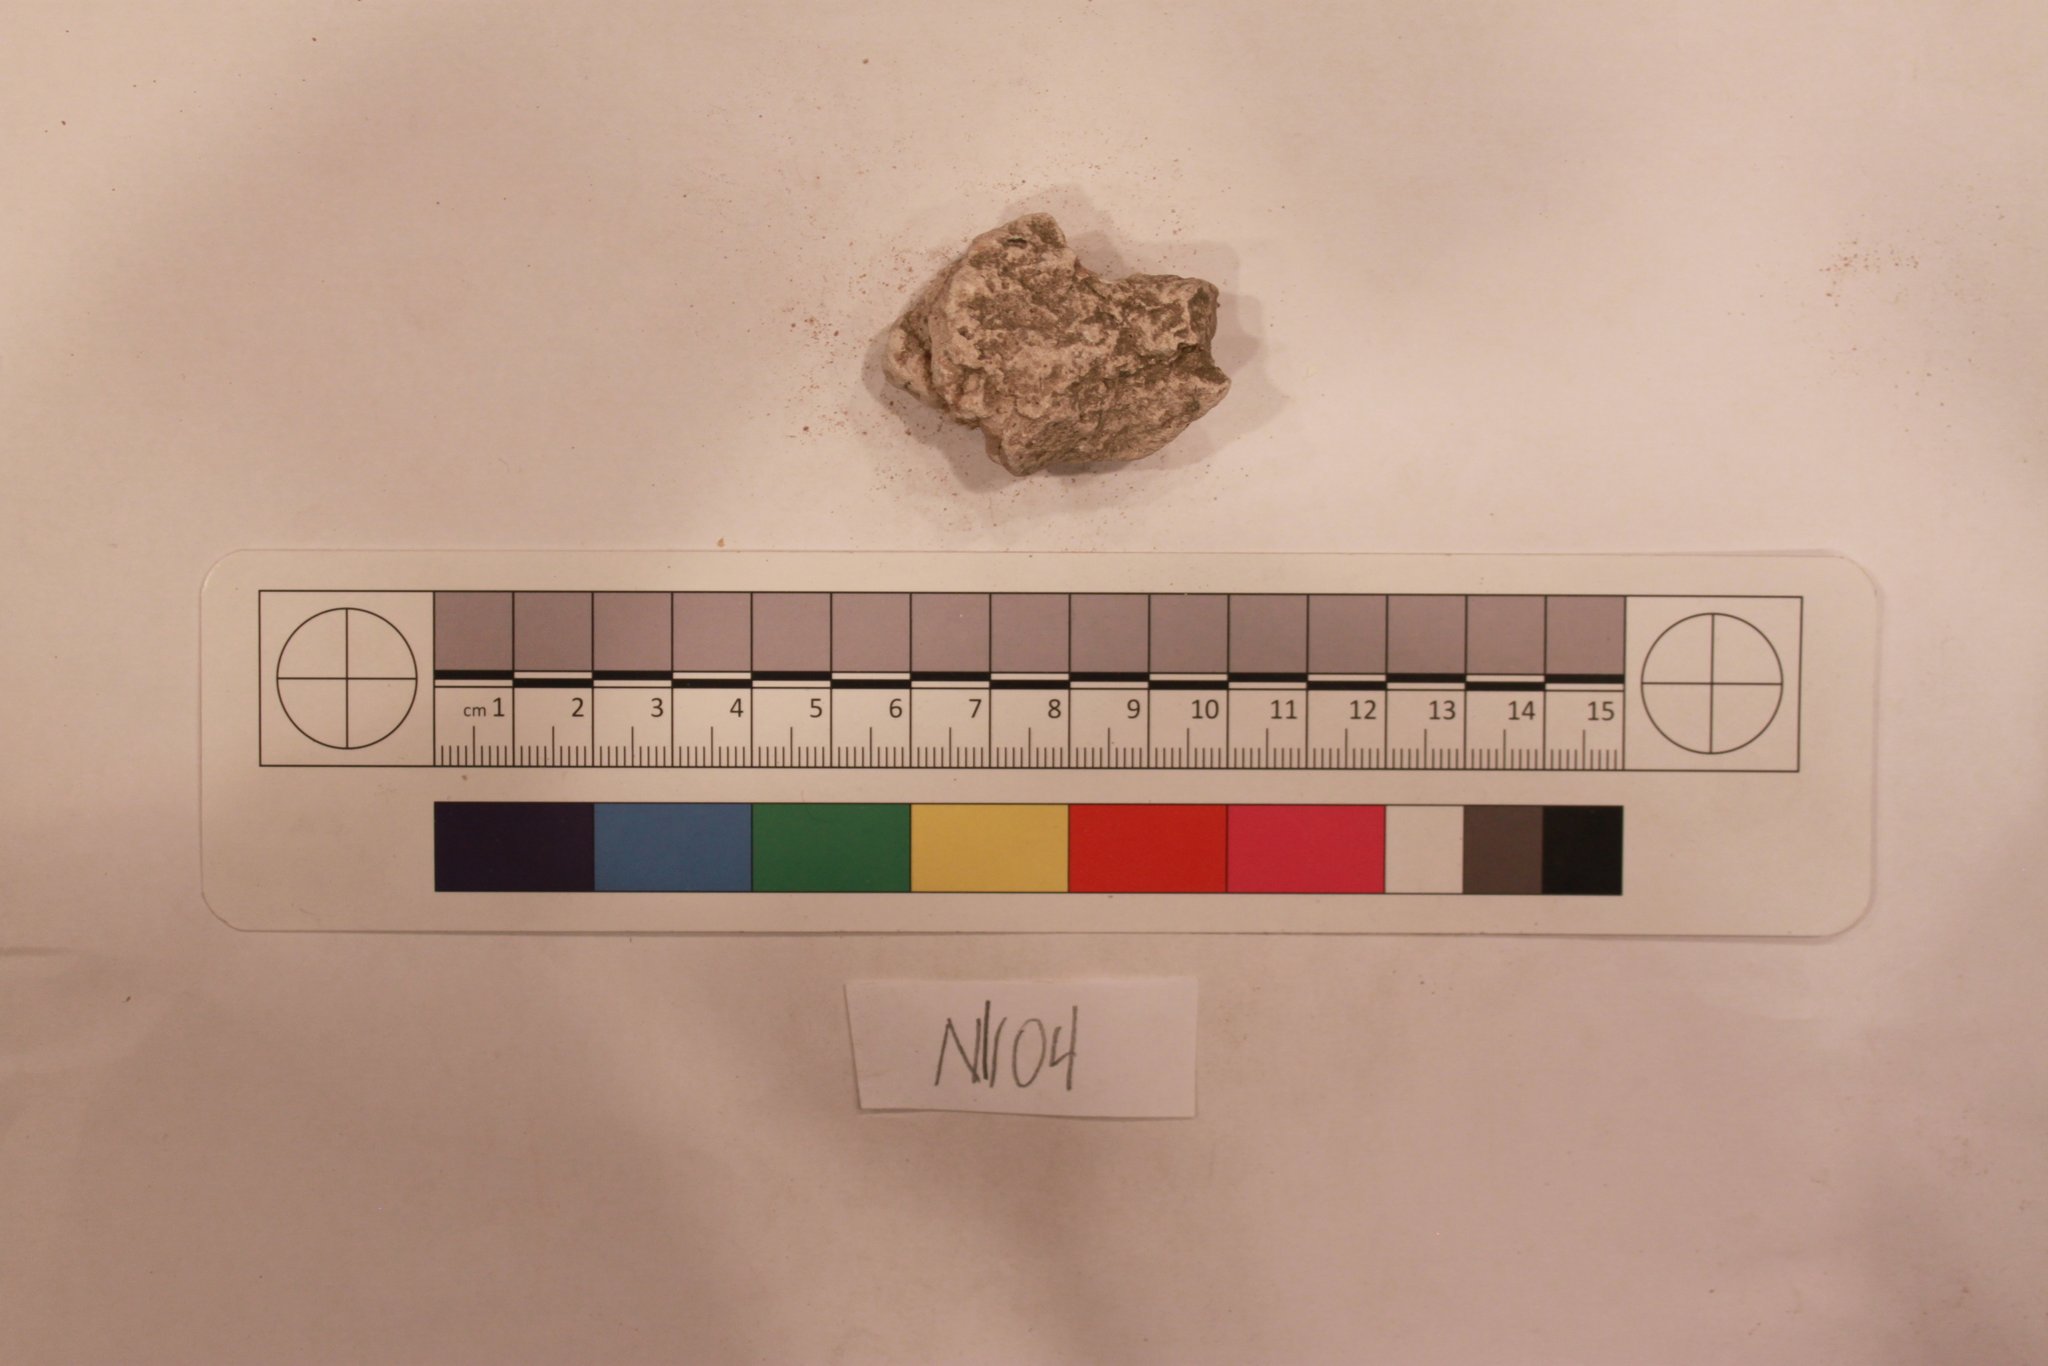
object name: fragment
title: Stucco Fragment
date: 701-1200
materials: plaster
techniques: carving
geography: iran